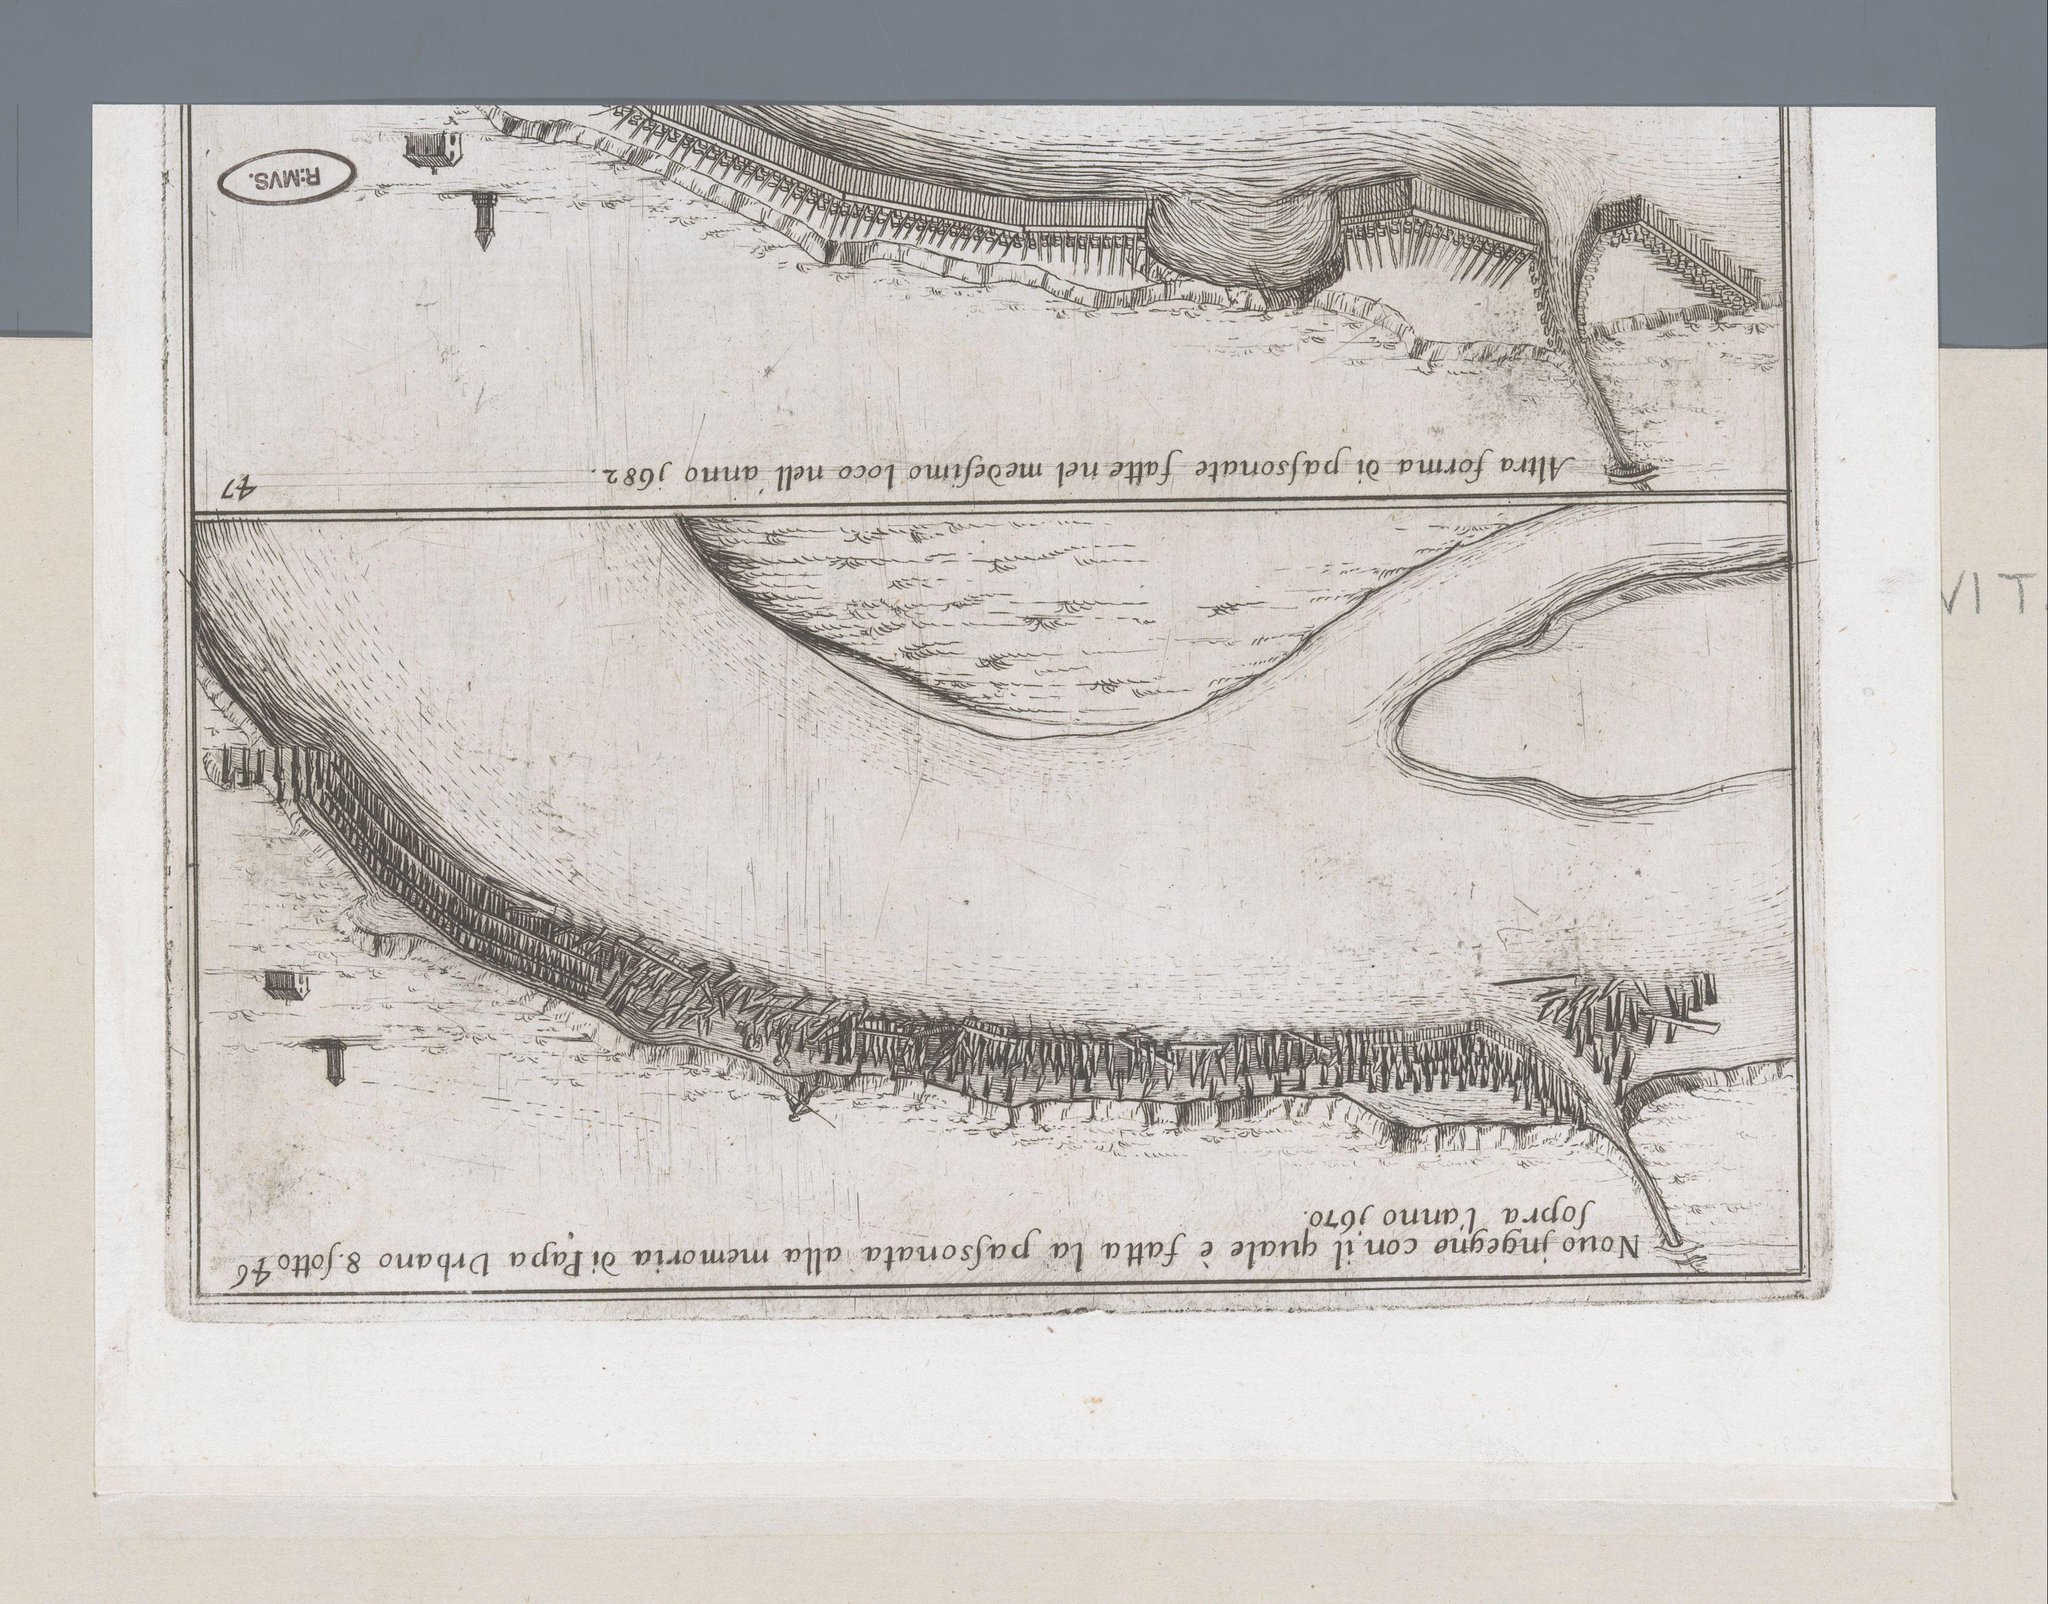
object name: print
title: Twee voorstellingen van dammen in dezelfde rivier in 1670 en 1682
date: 1696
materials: paper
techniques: etching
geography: rome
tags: river, dam (in canal)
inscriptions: collector's mark: Lugt 2228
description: Prent mogelijk uit: L'arte di rendere i fiumi navigabili, in varij modi, con altre nuove inventioni, e varij altri segreti. Rome: Giovanni Giacomo Komarek, 1696.